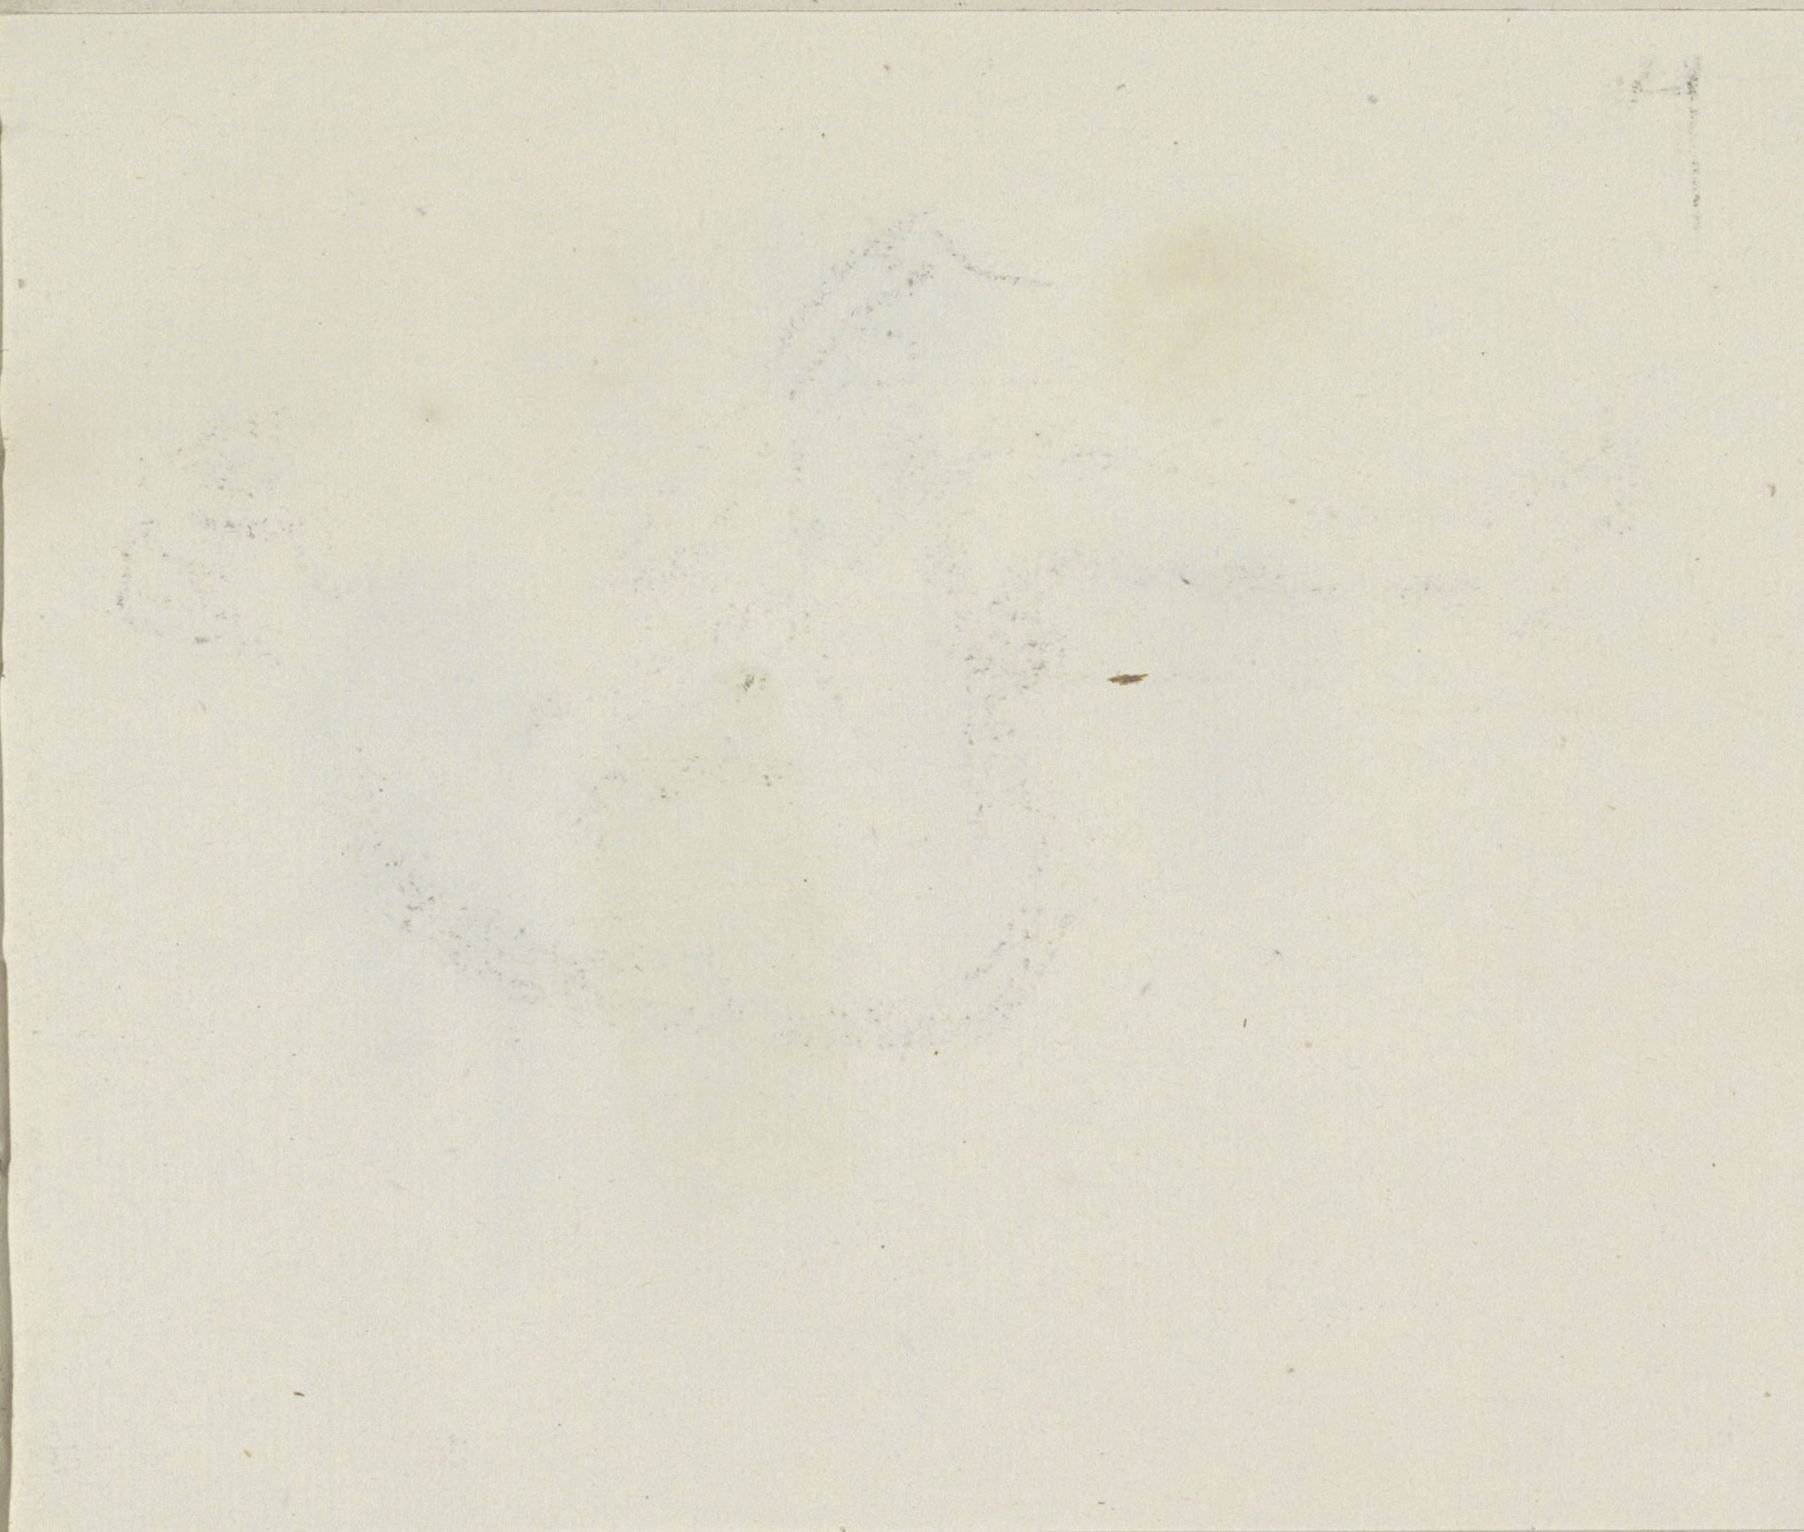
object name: sketchbook leaf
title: Abklatsch van de potloodtekening op blad 8 verso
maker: willem witsen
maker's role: draughtsman, painter, print maker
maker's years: 1860-1923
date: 1915-1920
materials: paper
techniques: printmaking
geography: amsterdam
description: Blad 9 recto uit een schetsboek met 12 bladen.